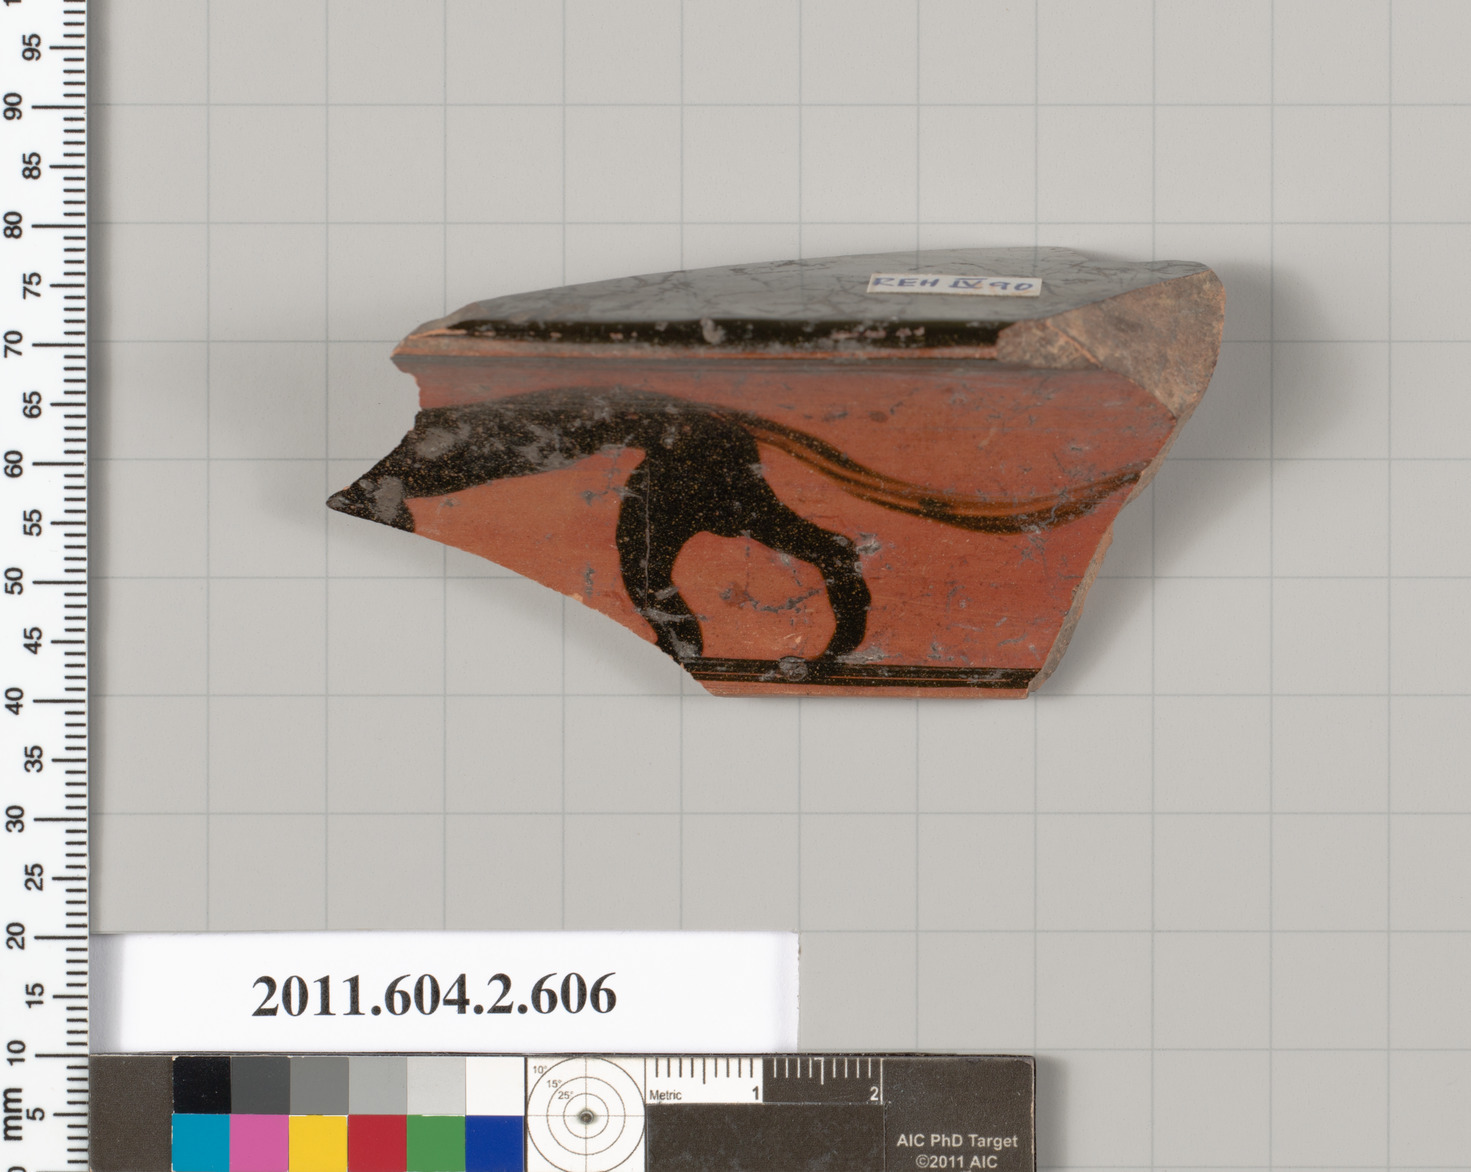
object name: column krater fragment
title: Terracotta fragment of a column-krater (bowl for mixing wine and water)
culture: greek, attic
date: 475-451 BCE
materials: terracotta